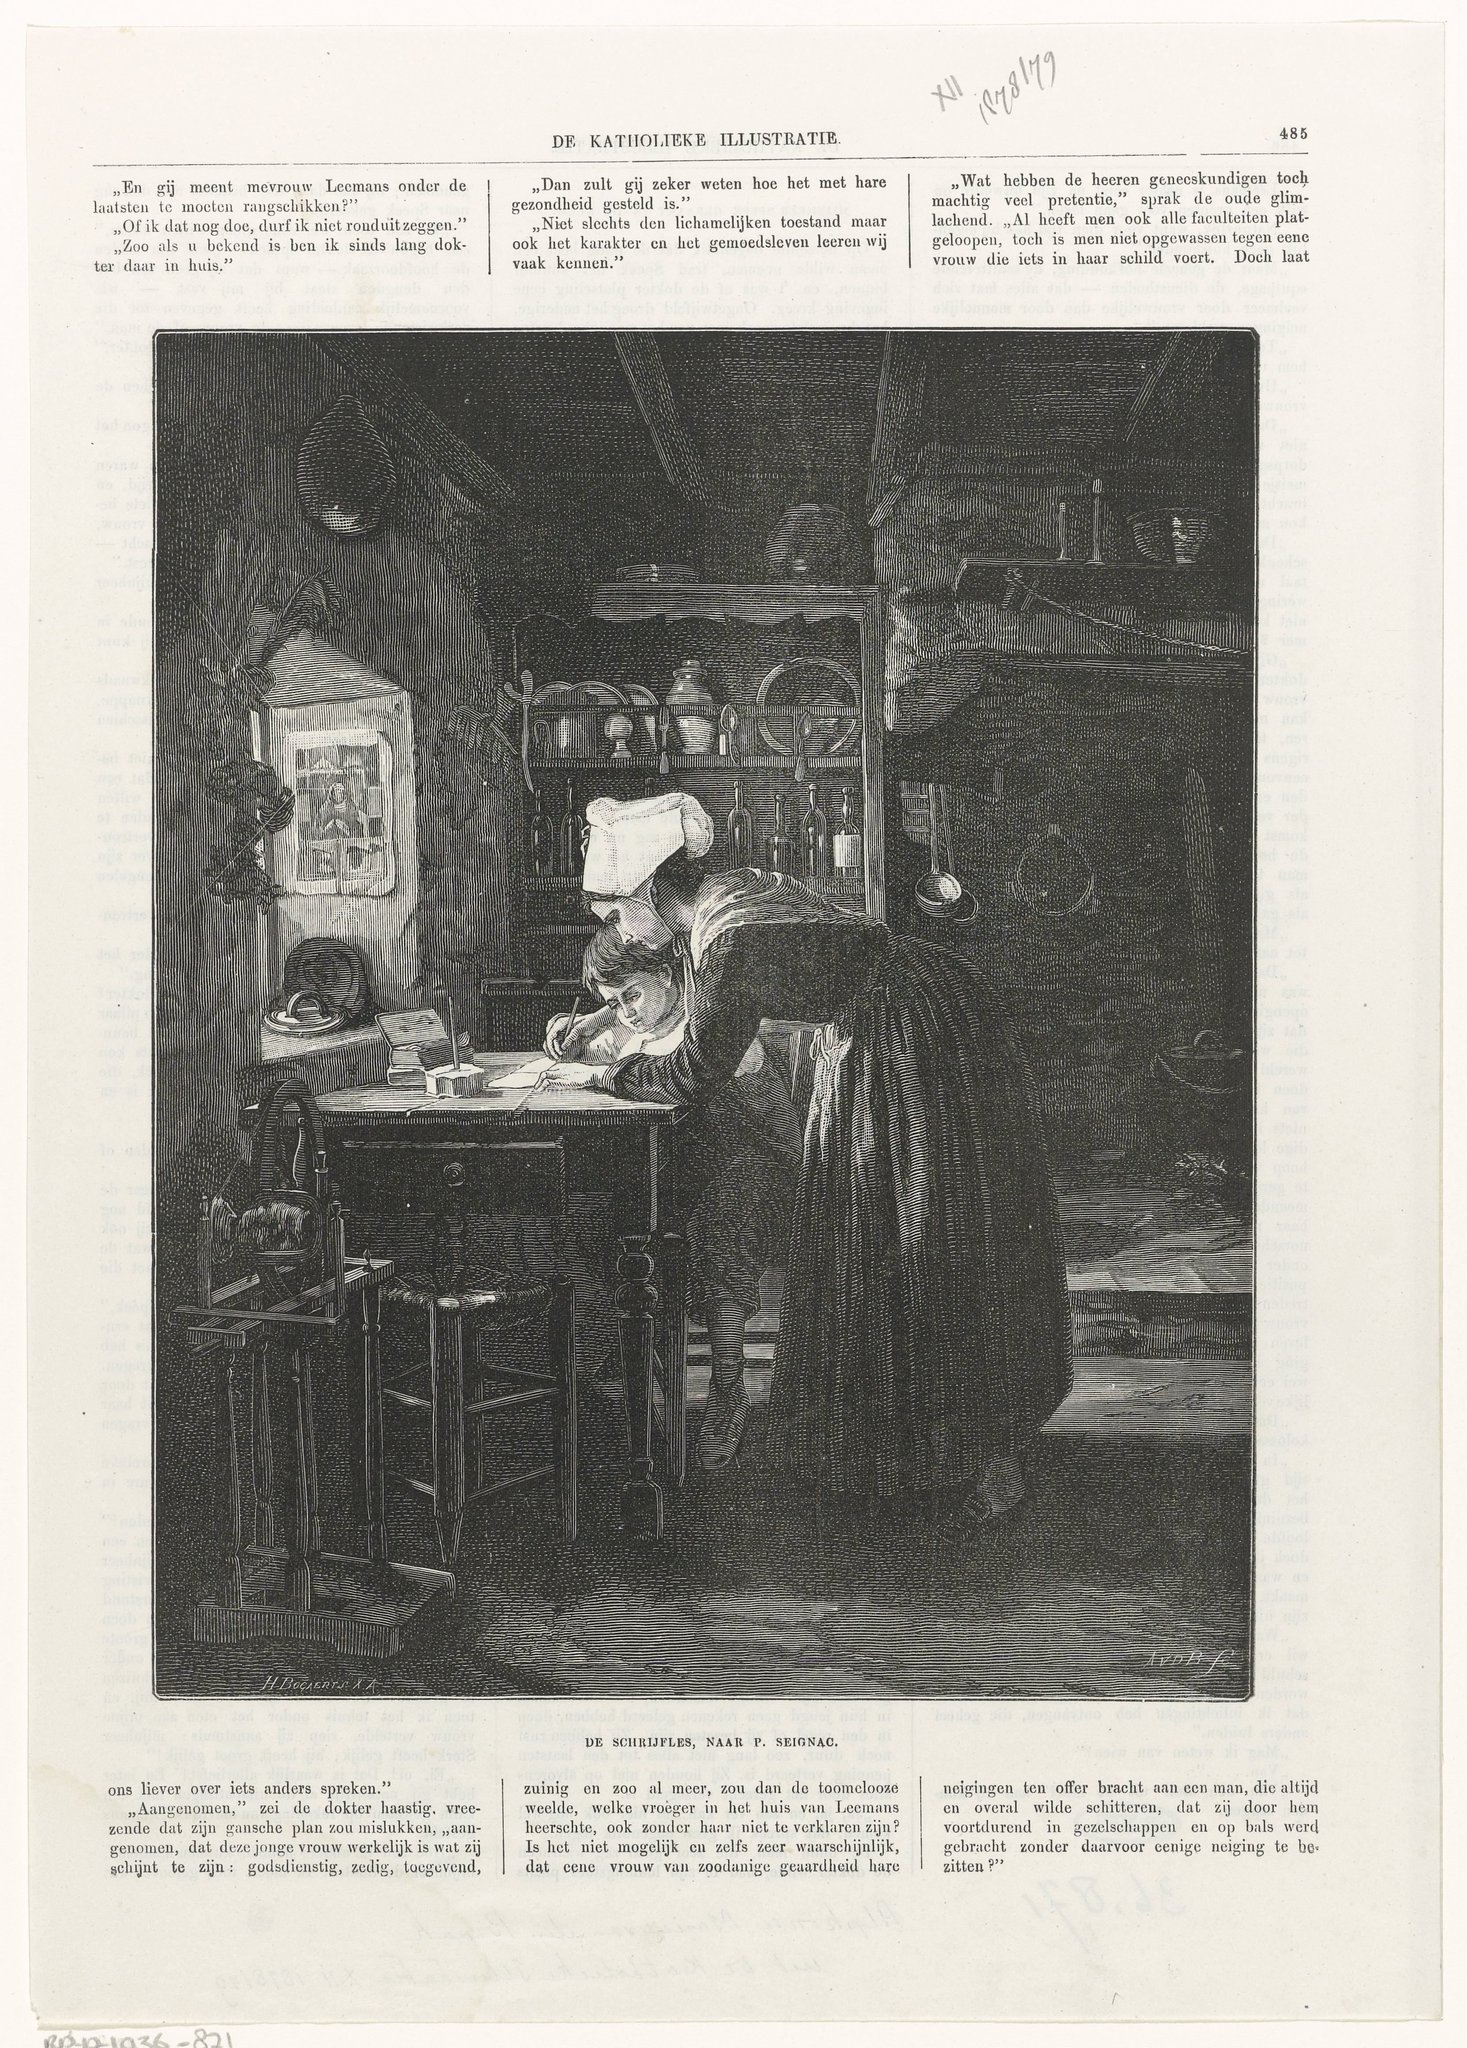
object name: print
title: De schrijfles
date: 1878-1879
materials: paper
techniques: letterpress printing, engraving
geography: netherlands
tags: kitchen-utensils, education, science and learning, spinning-wheel, writing accessories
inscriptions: collector's mark: Lugt 2228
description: Een jongen zit aan een bureau met daarop schrijfgerei en krijgt schrijfles van een vrouw. In het vertrek staat een spinnewiel, keukenbenodigdheden en er hangt een voorstelling op papier in het raamkozijn.